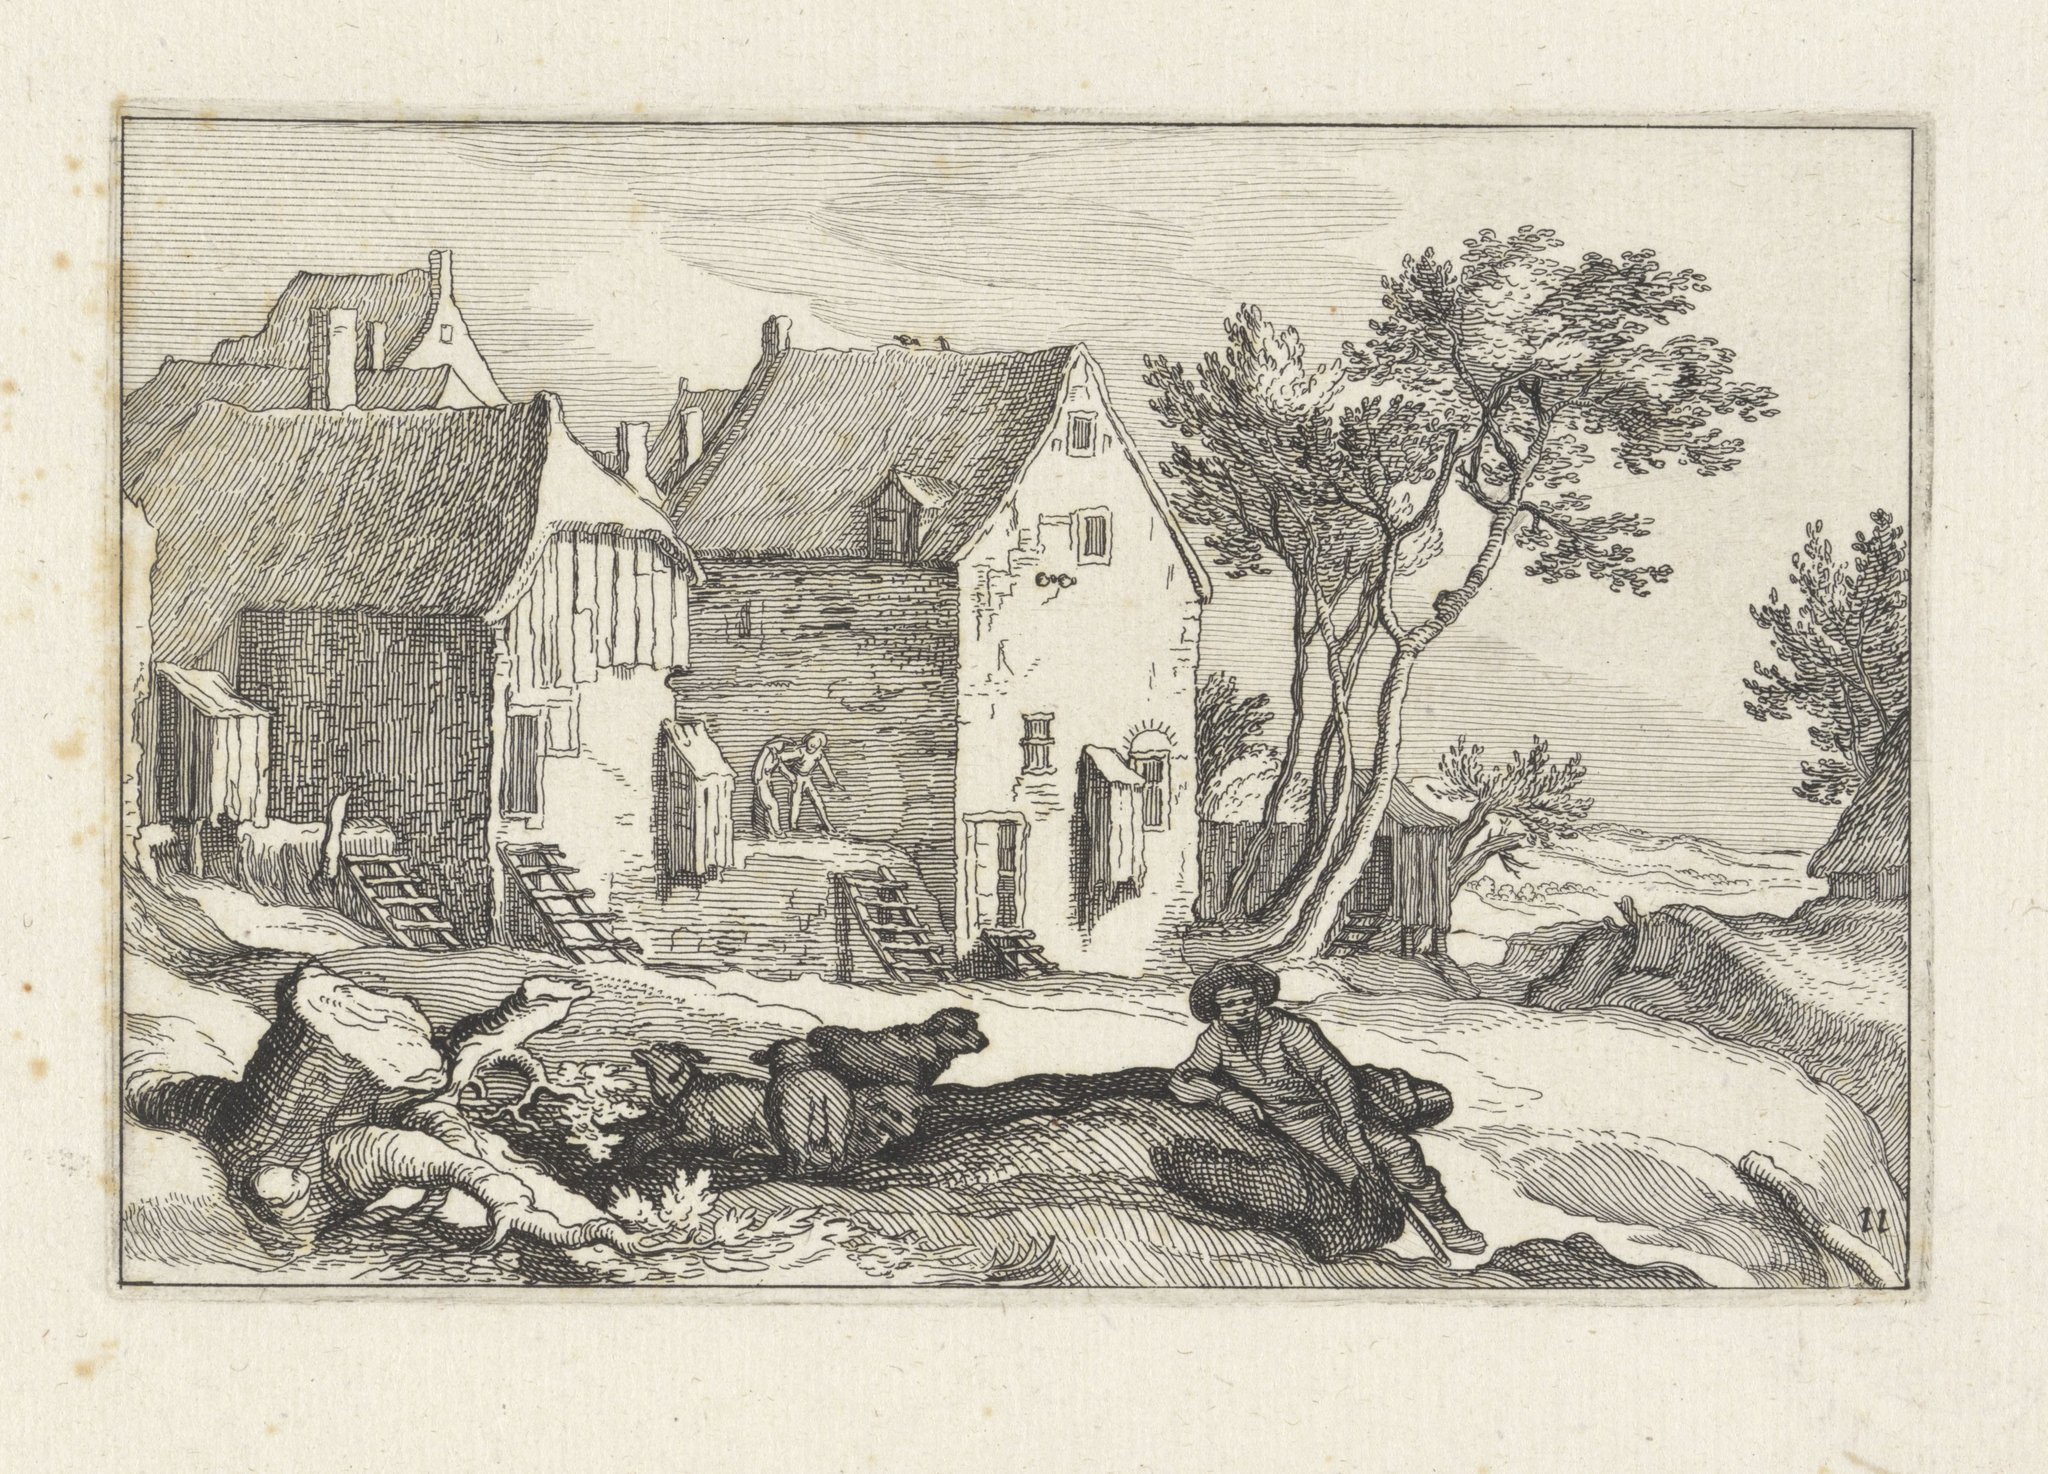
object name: print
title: Boerderij en herder met schapen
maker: claes jansz. visscher (ii)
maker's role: draughtsman, print maker, publisher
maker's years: 1586-1652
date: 1620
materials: paper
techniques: etching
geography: amsterdam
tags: herding, herdsman, herdswoman, shepherd, shepherdess, cowherd, etc., sheep, farm or solitary house in landscape, farm (building)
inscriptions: collector's mark: Lugt 240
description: Gezicht op een stenen boerderij in een landschap met op de voorgrond een herder met zijn schapen.